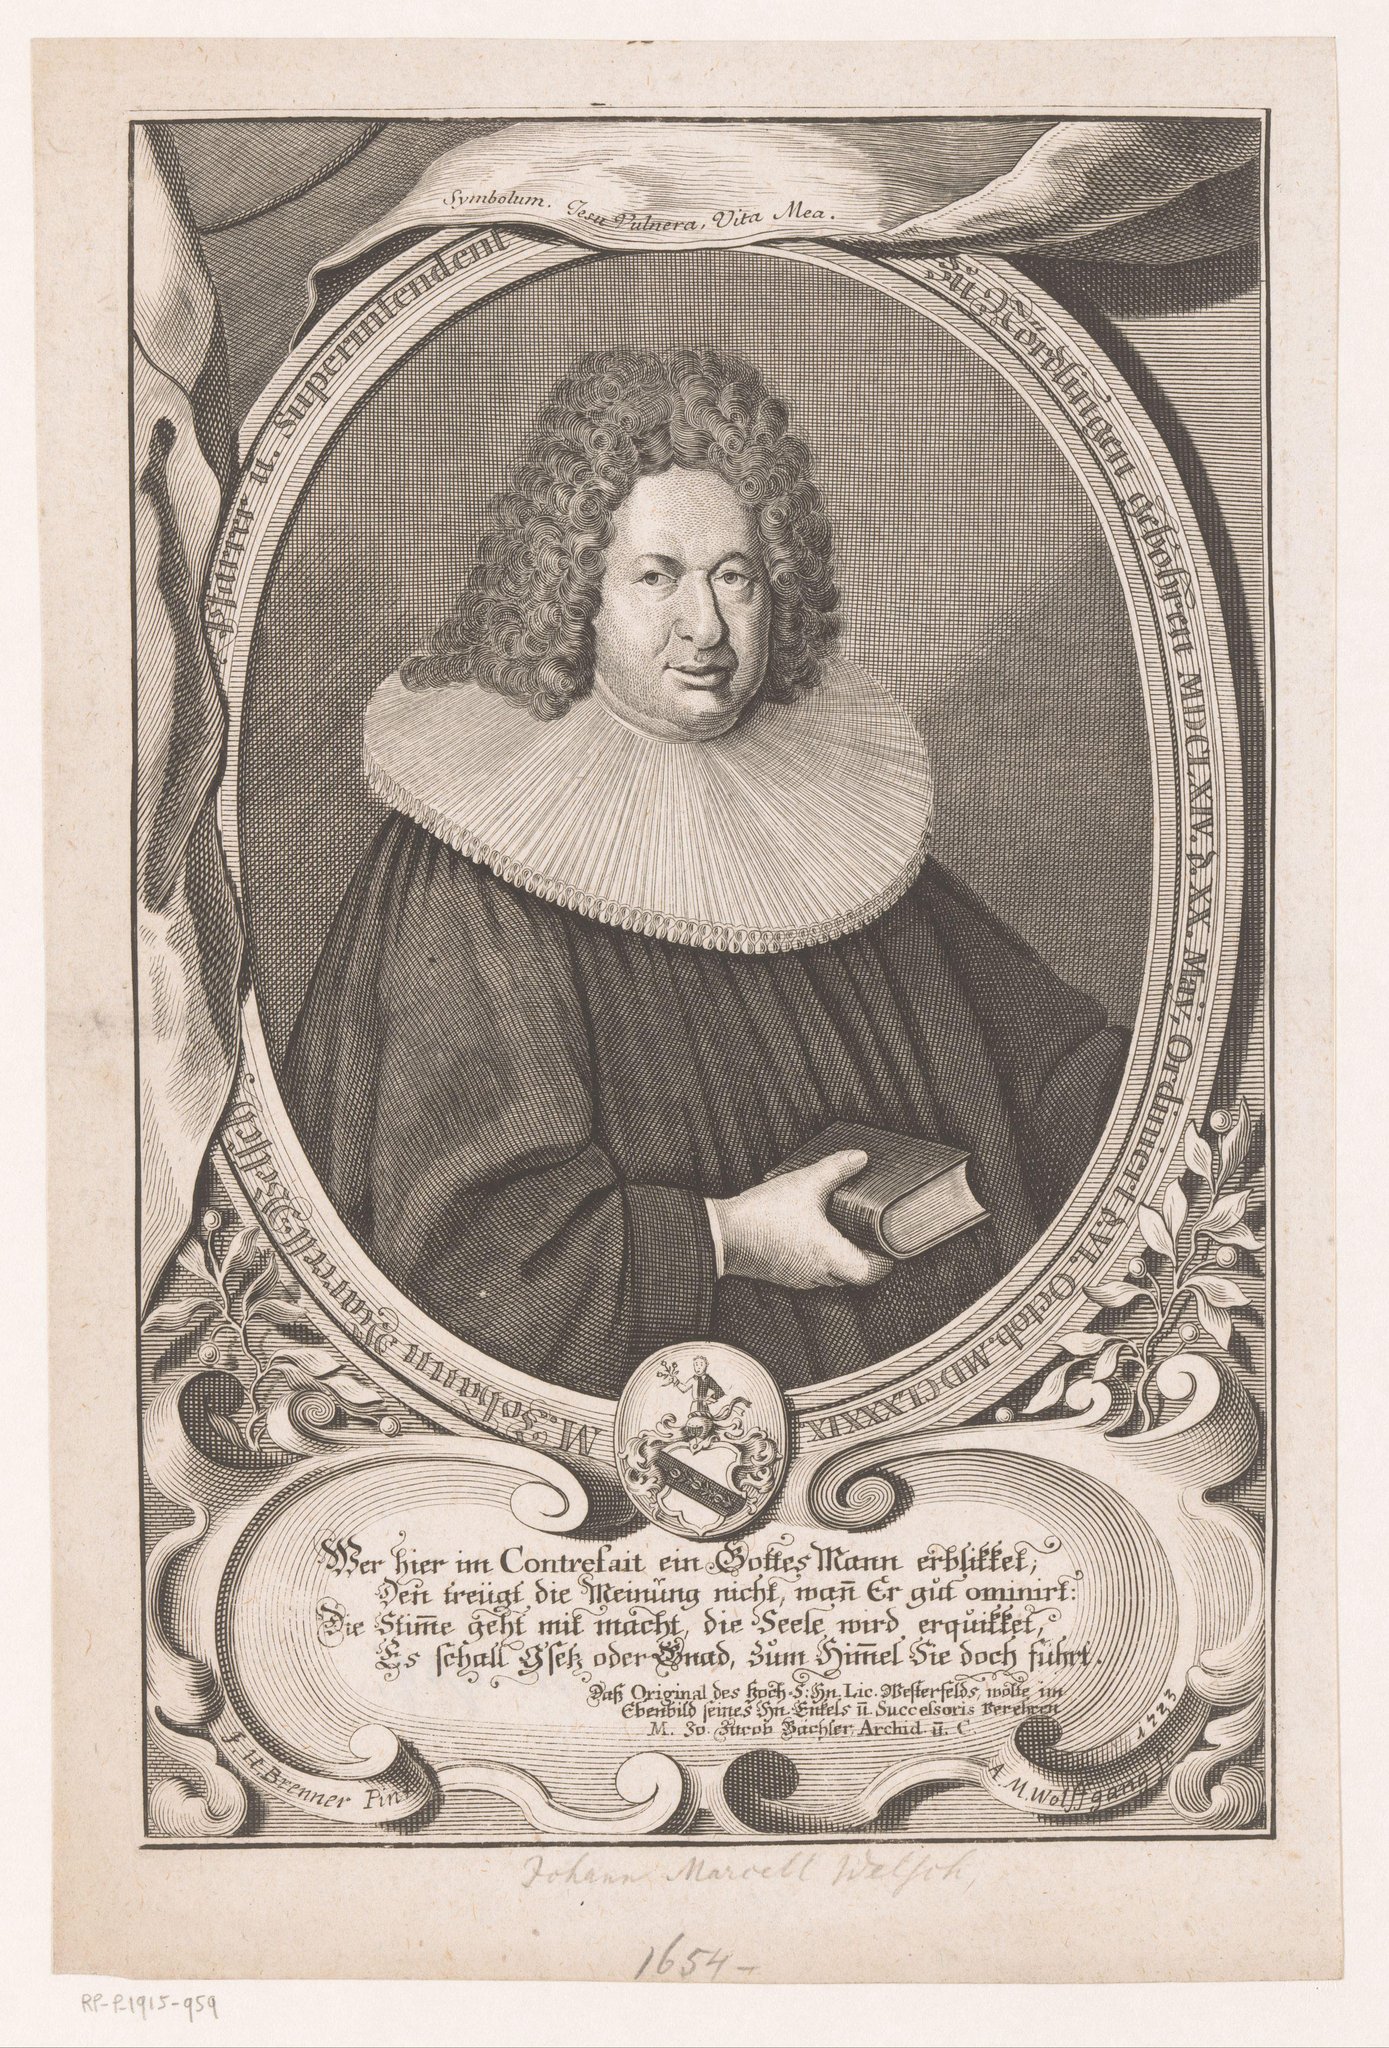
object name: print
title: Portret van Johann Marcell Welsch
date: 1733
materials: paper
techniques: engraving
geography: germany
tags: historical persons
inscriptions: collector's mark: Lugt 2228